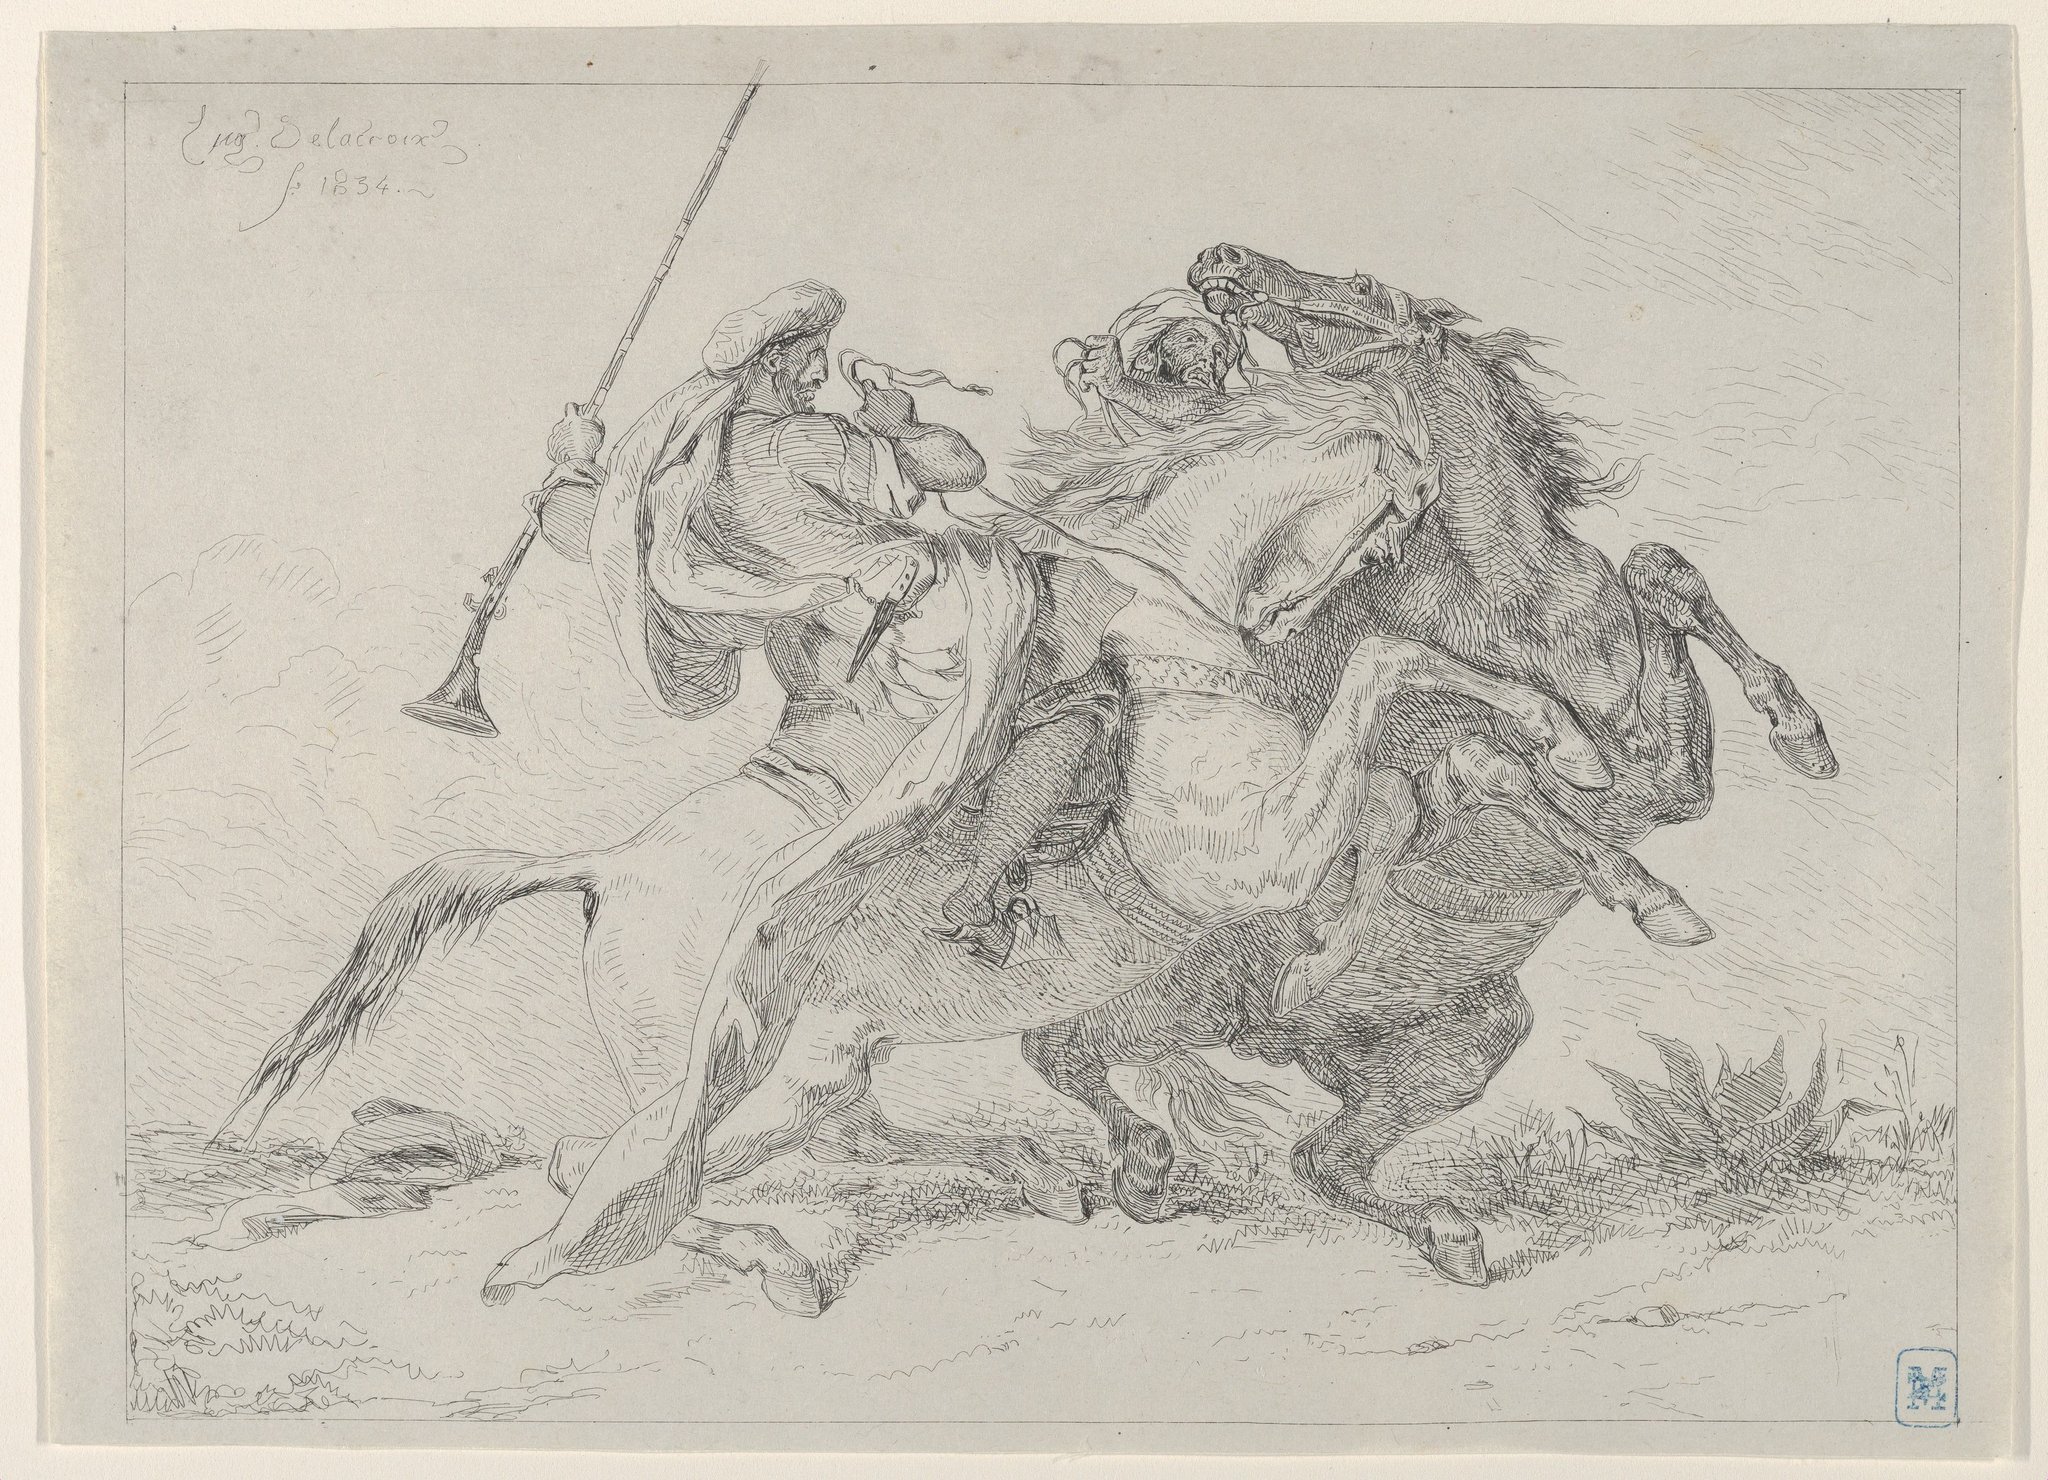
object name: print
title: Collision of Moorish Horsemen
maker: eugène delacroix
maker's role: artist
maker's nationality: french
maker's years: 1798-1863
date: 1834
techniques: etching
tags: weapons,men,horses